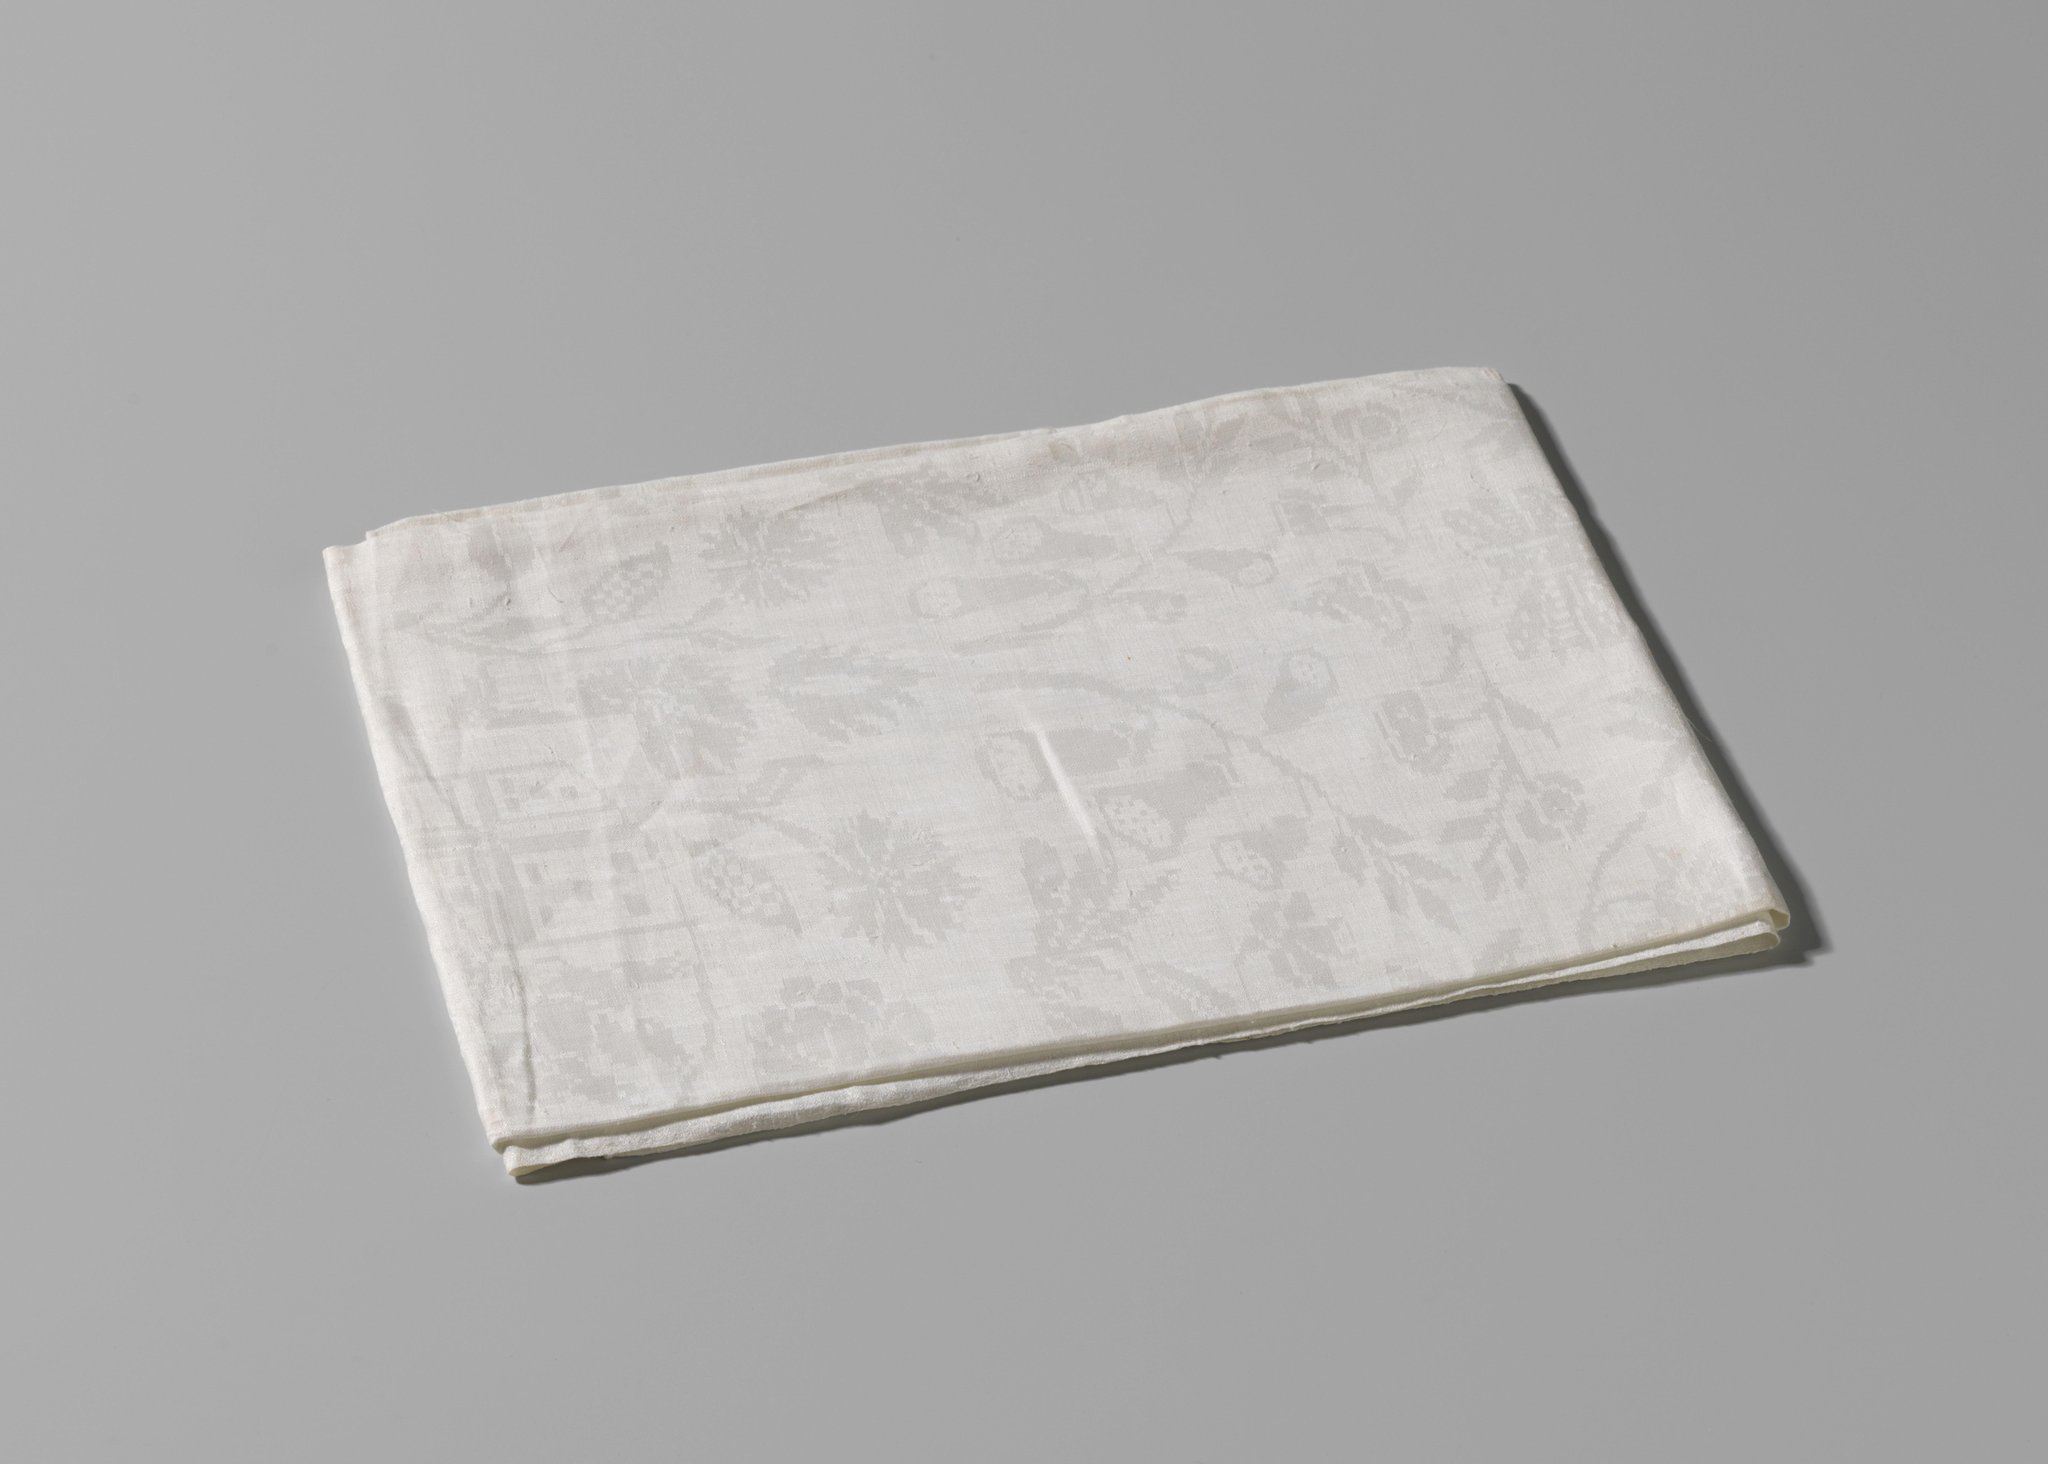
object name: woven material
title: Servet van wit linnendamast met de gekoppelde wapens Von Inn- und Kniphausen en Van Ewsum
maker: Anonymous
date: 1665-1670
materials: linen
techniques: damask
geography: northern netherlands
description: Servet van wit linnendamast met bloempatroon rondom de gekoppelde wapens Von Inn- und Kniphausen en Van Ewsum. Gemerkt: kroon LE 17.